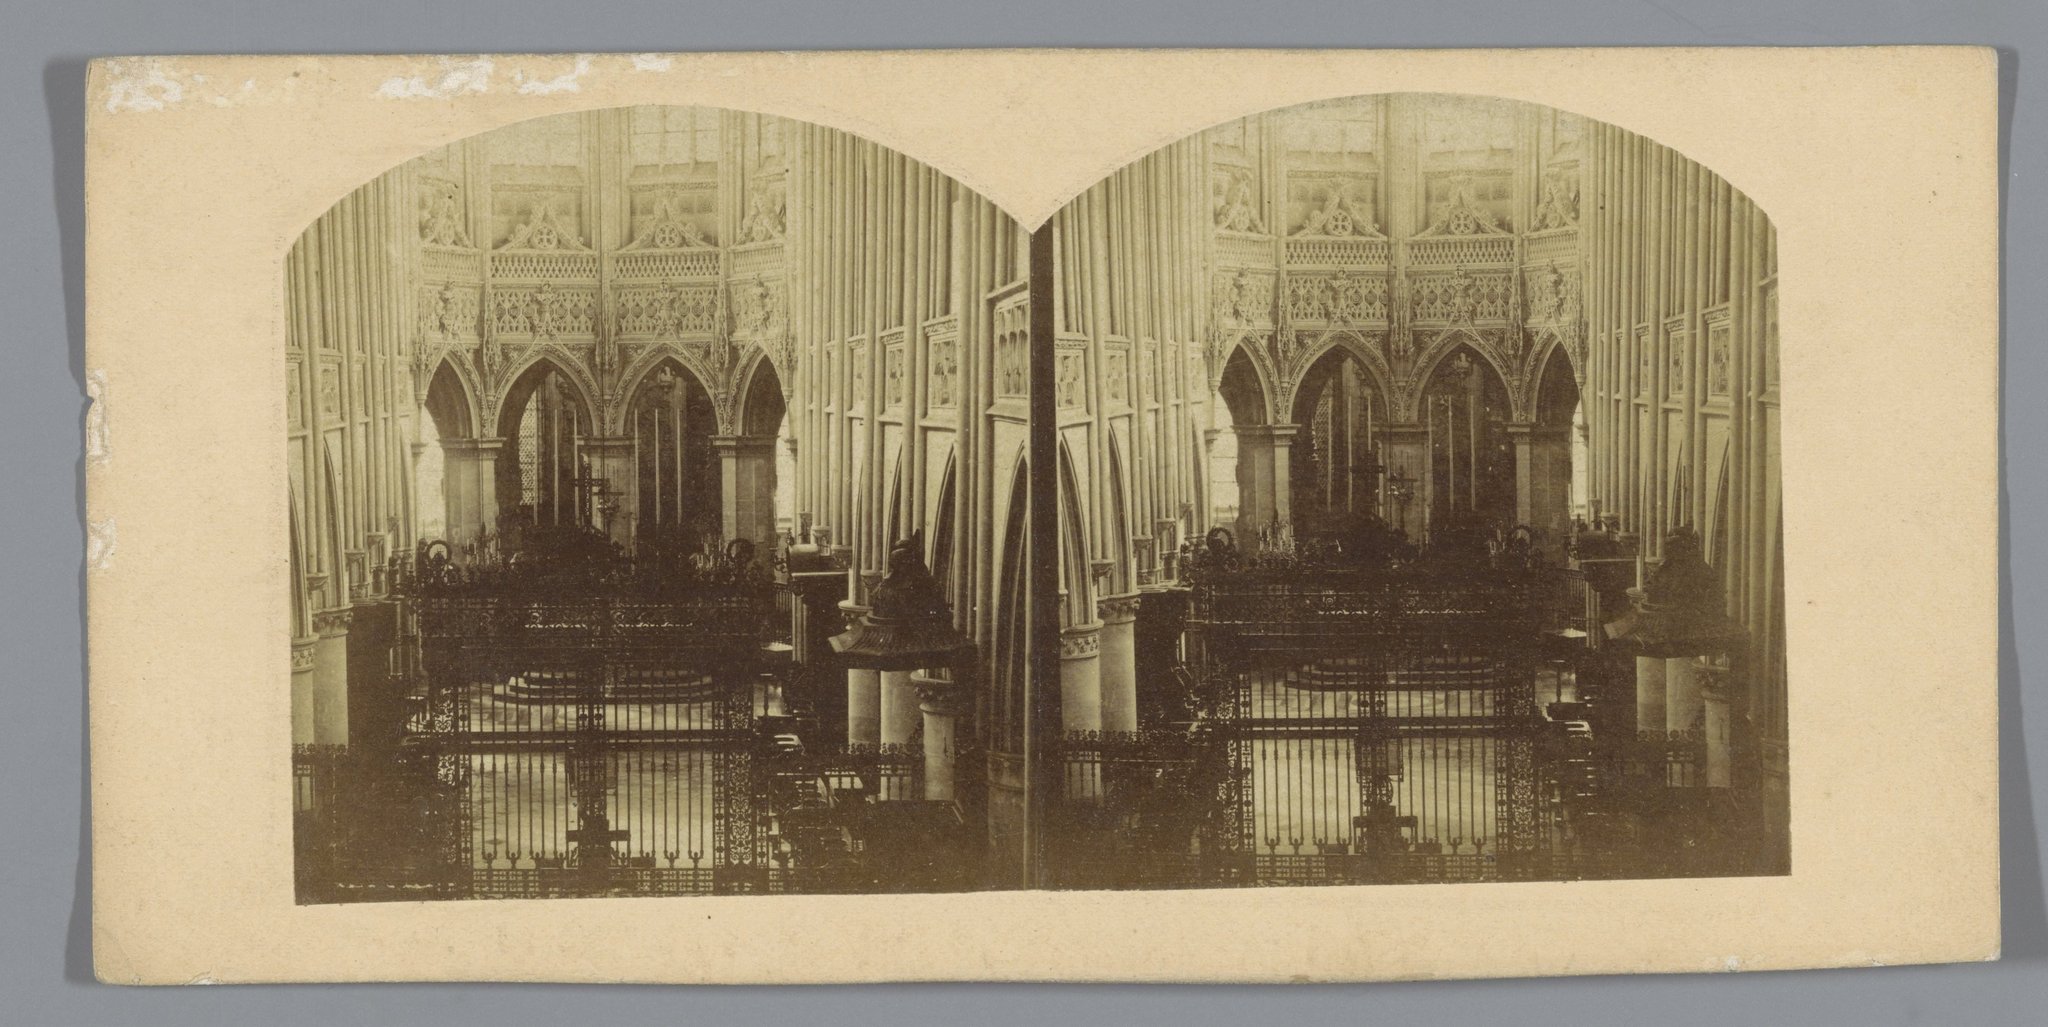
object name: stereograph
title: Kerkinterieur met koorhek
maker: Anonymous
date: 1852-1863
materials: cardboard, paper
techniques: albumen print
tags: parts of church interior: choir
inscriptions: number: ‘No.28./ 25’